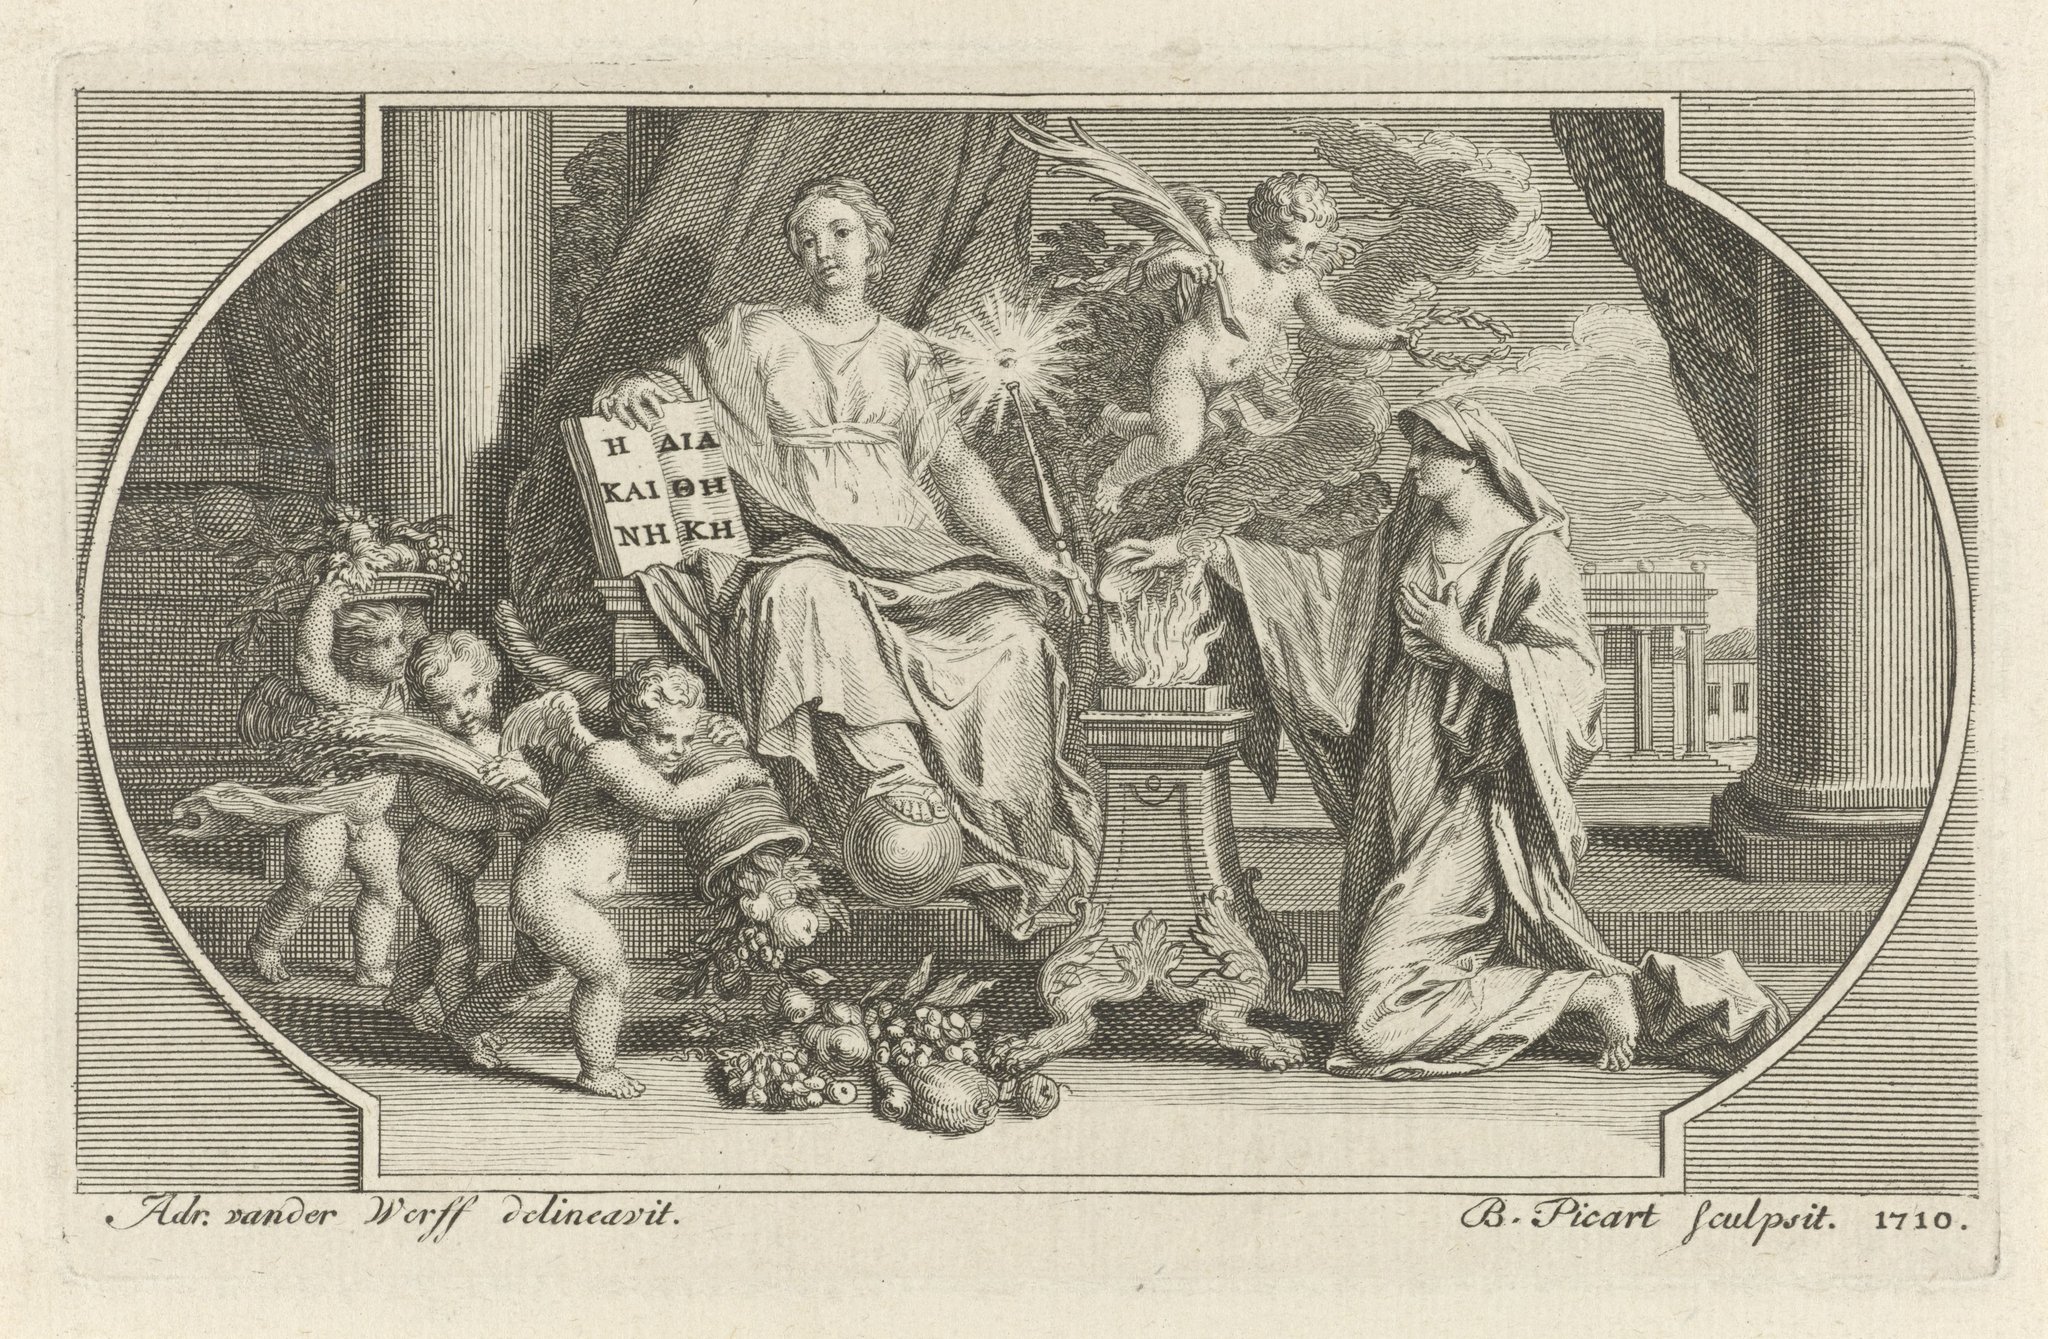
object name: print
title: Voorzienigheid en Godsvrucht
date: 1710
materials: paper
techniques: engraving, etching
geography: amsterdam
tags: 'pietas'; 'pietà' (ripa), 'cornucopia', horn of plenty, god's perfections, forethought, deliberation; 'previdenza', 'providenza' (ripa), crowning with laurel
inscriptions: collector's mark: Lugt 2228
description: Voorzienigheid (Providentia) zit op een troon en rust met haar voeten op een globe. In haar handen houdt ze een staf met het Alziend oog als symbool van God de Vader. Een putto gooit een hoorn des overvloeds leeg aan haar voeten. Ze wordt vergezeld door Godsvrucht (Pietas), die met haar hand tegen de borst knielt voor een offerzuil. Ze wordt gelauwerd door een putto.